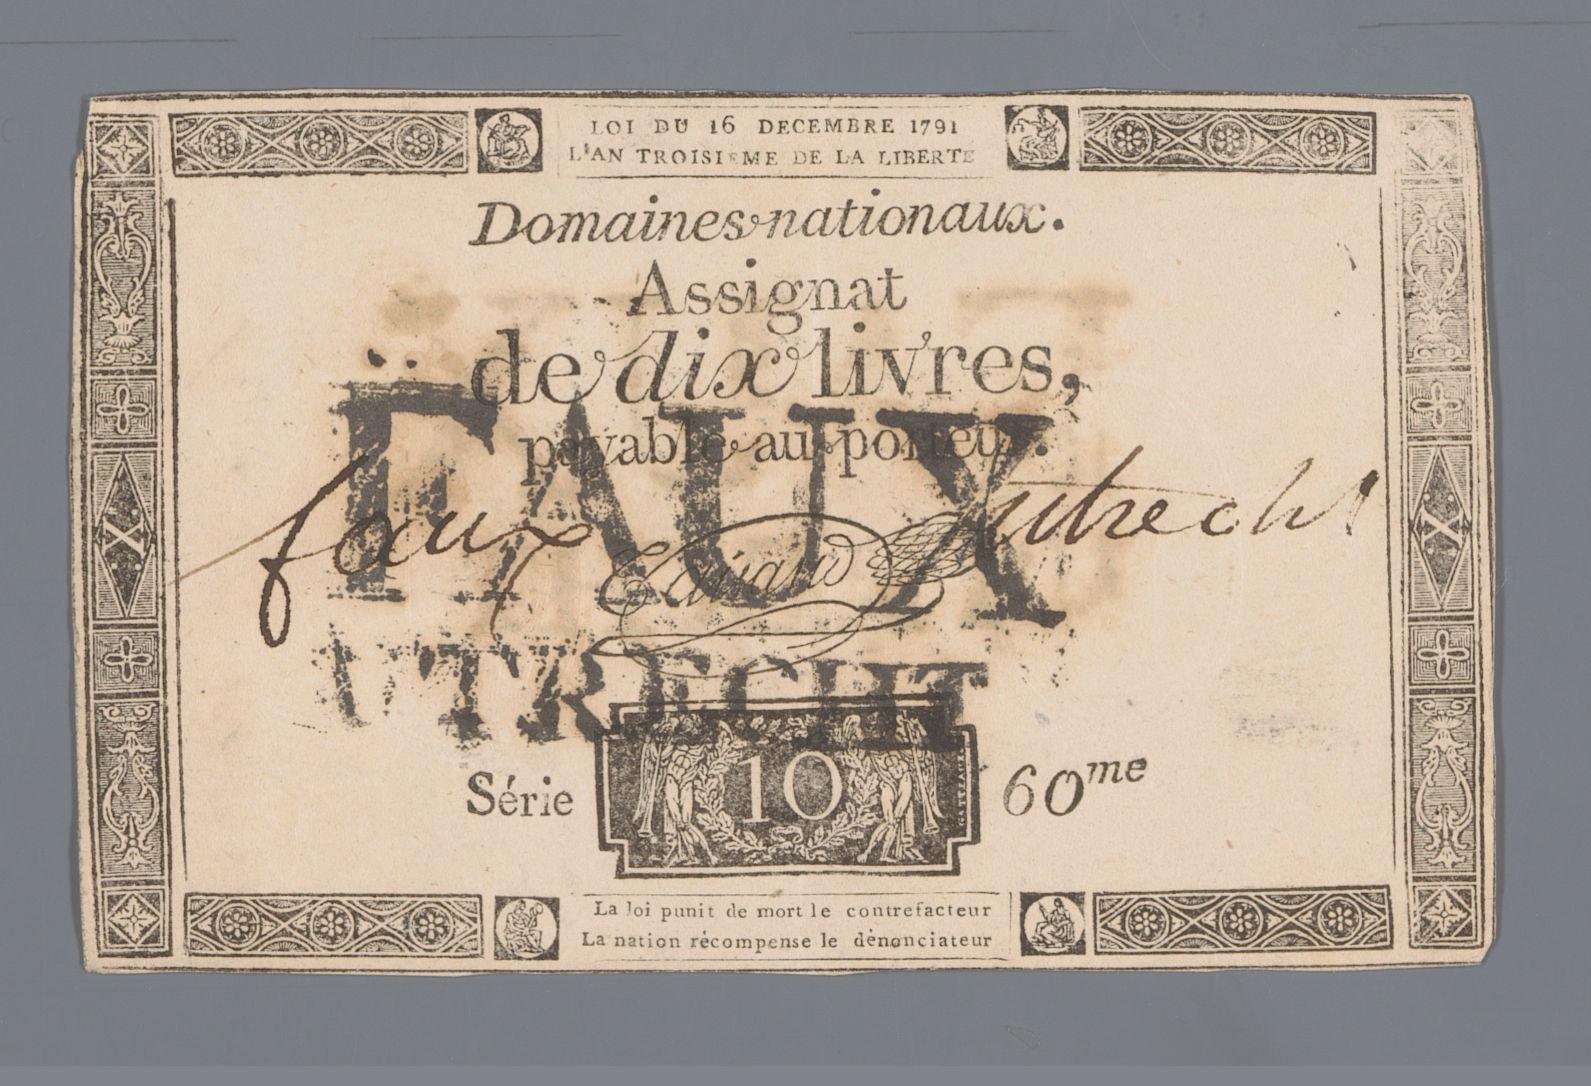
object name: assignat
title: Te Utrecht ongeldig gemaakte assignat van tien livres, serie 60, uitgegeven 16 december 1791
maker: Anonymous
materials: paper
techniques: printing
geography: paris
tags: utrecht, france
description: Eenzijdig bedrukte papiertje, assignaat van £10, met stempel 'Faux Utrecht' aan beide zijden. Nr. 60.